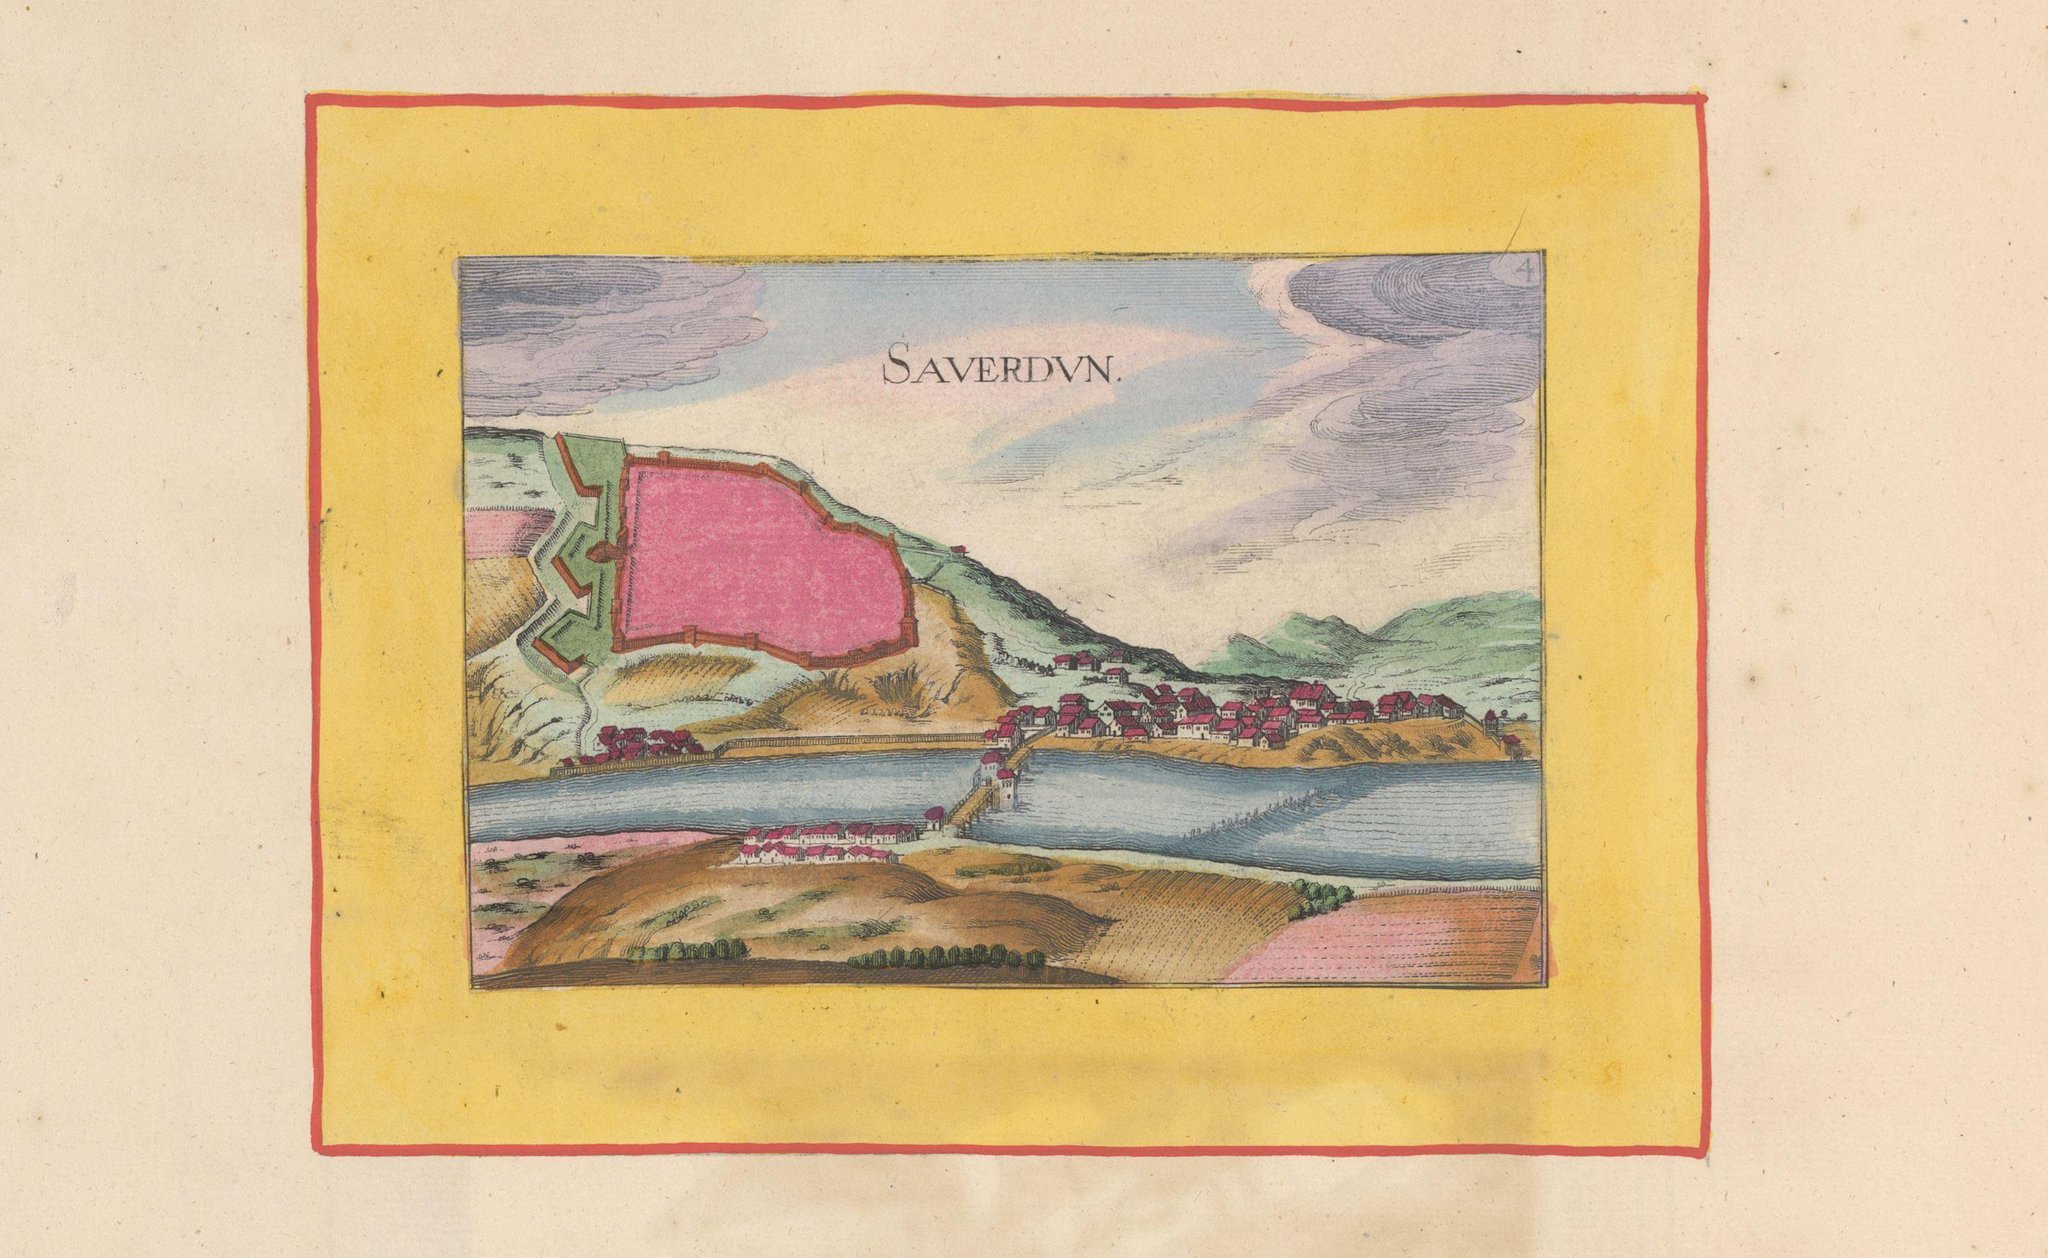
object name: print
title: Saverdun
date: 1638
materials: paper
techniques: engraving, etching, hand coloring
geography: paris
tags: city-view in general; 'veduta'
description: Prent uit: Tassin, Christophe. Les plans et profils de toutes les principales villes et lieux considérables de France (...). Parijs: Michel van Lochom, 1638, kaart 4 uit het deel 'Foix et Bearn'.